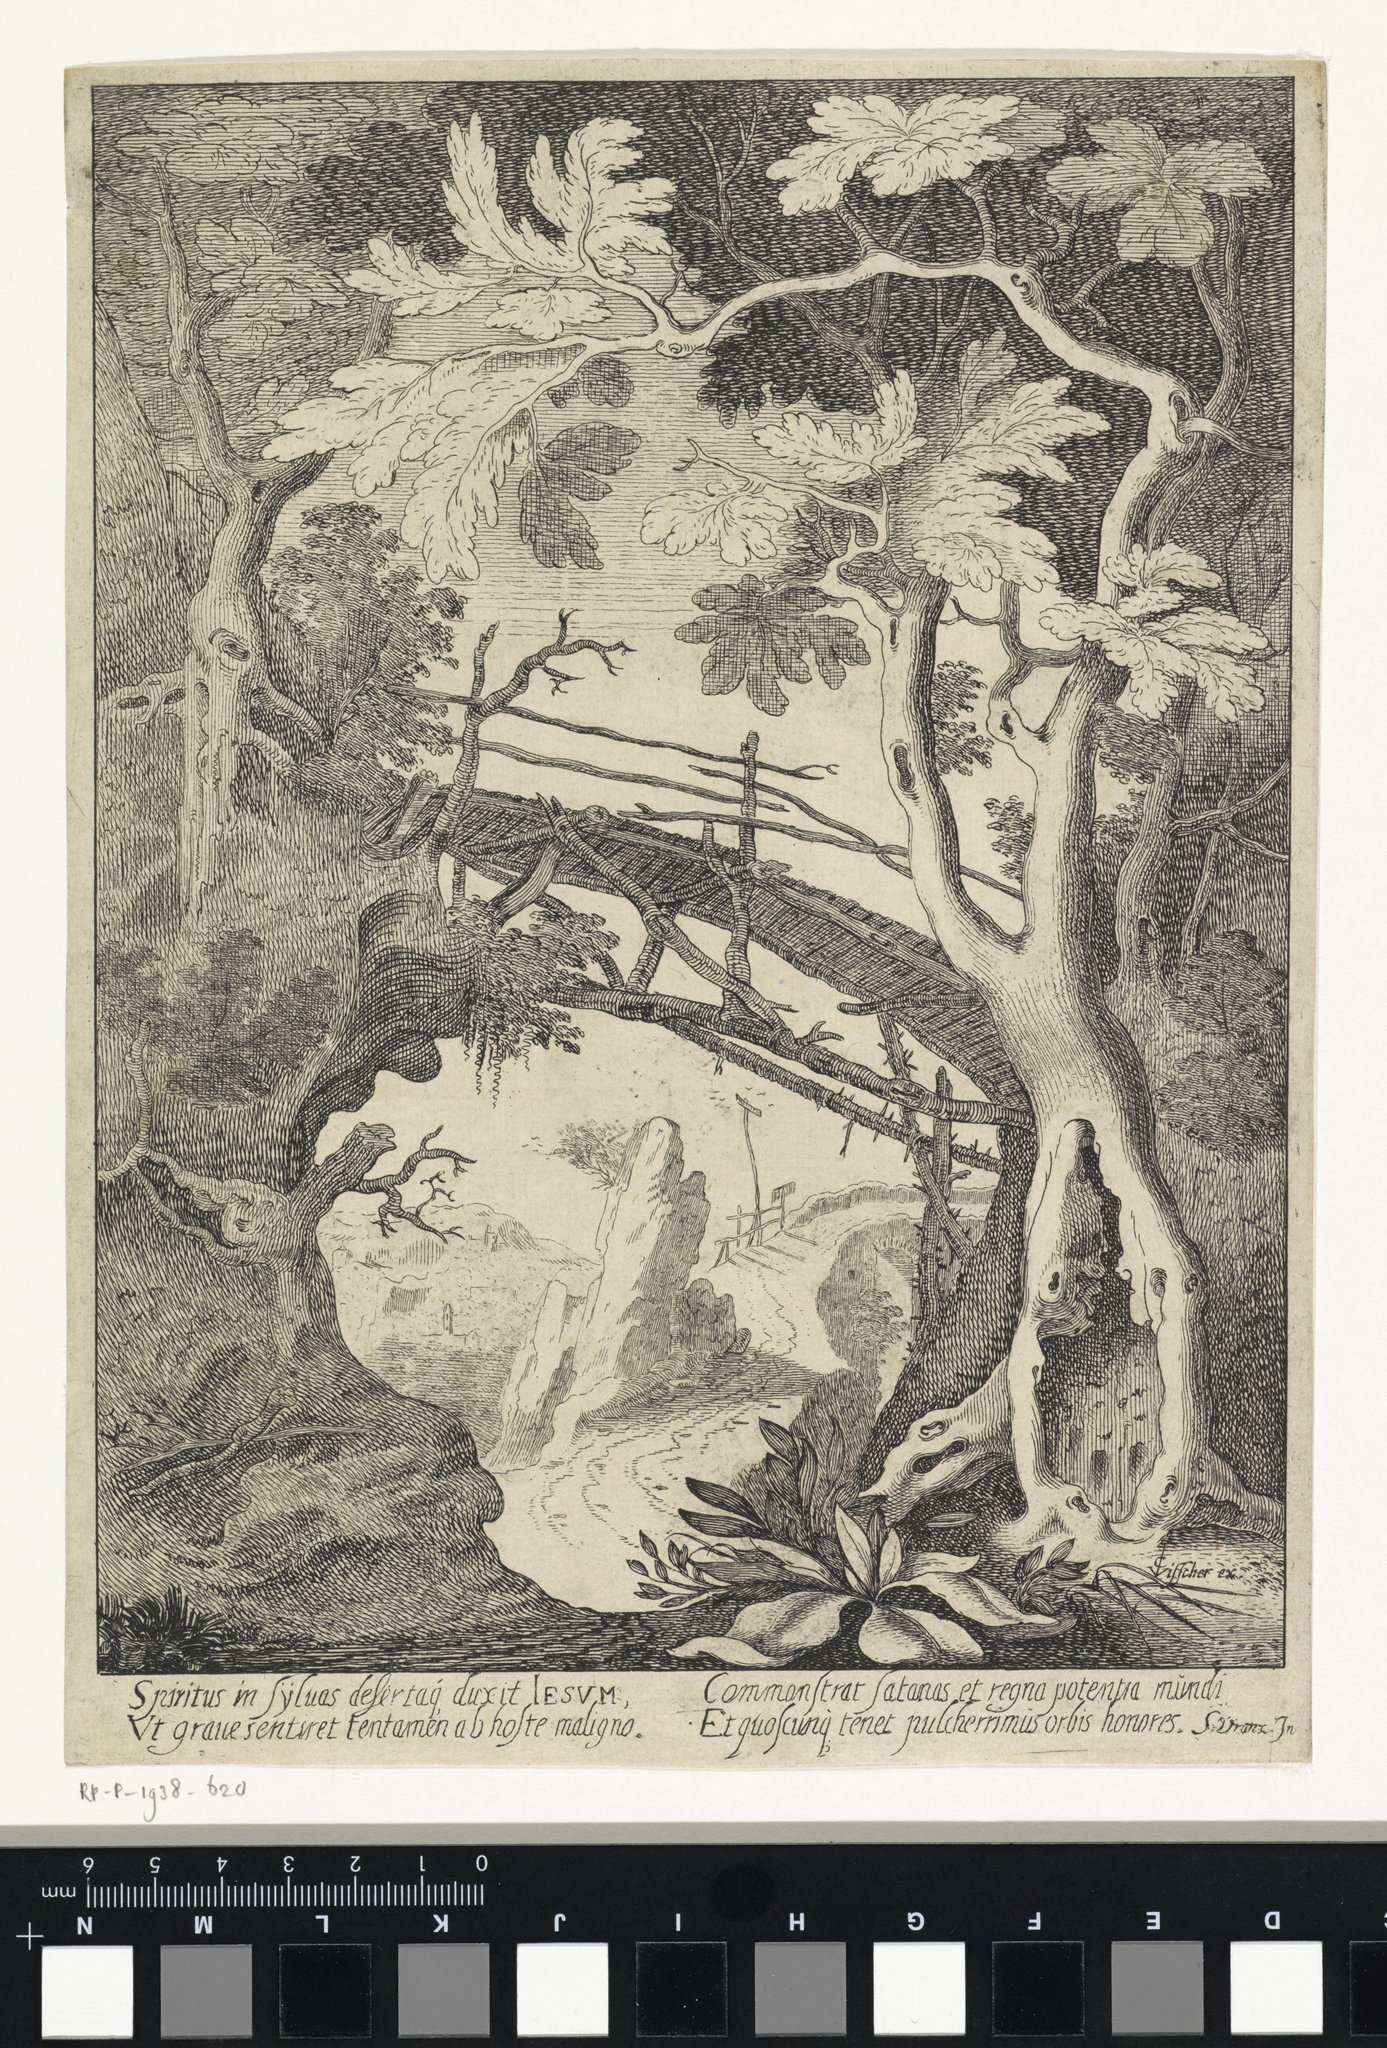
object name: print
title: Landschap met een houten brug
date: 1601-1652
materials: paper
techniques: engraving, etching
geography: amsterdam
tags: landscape with bridge, viaduct or aqueduct, bridge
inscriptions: collector's mark: Lugt 2760, collector's mark: Lugt 2228